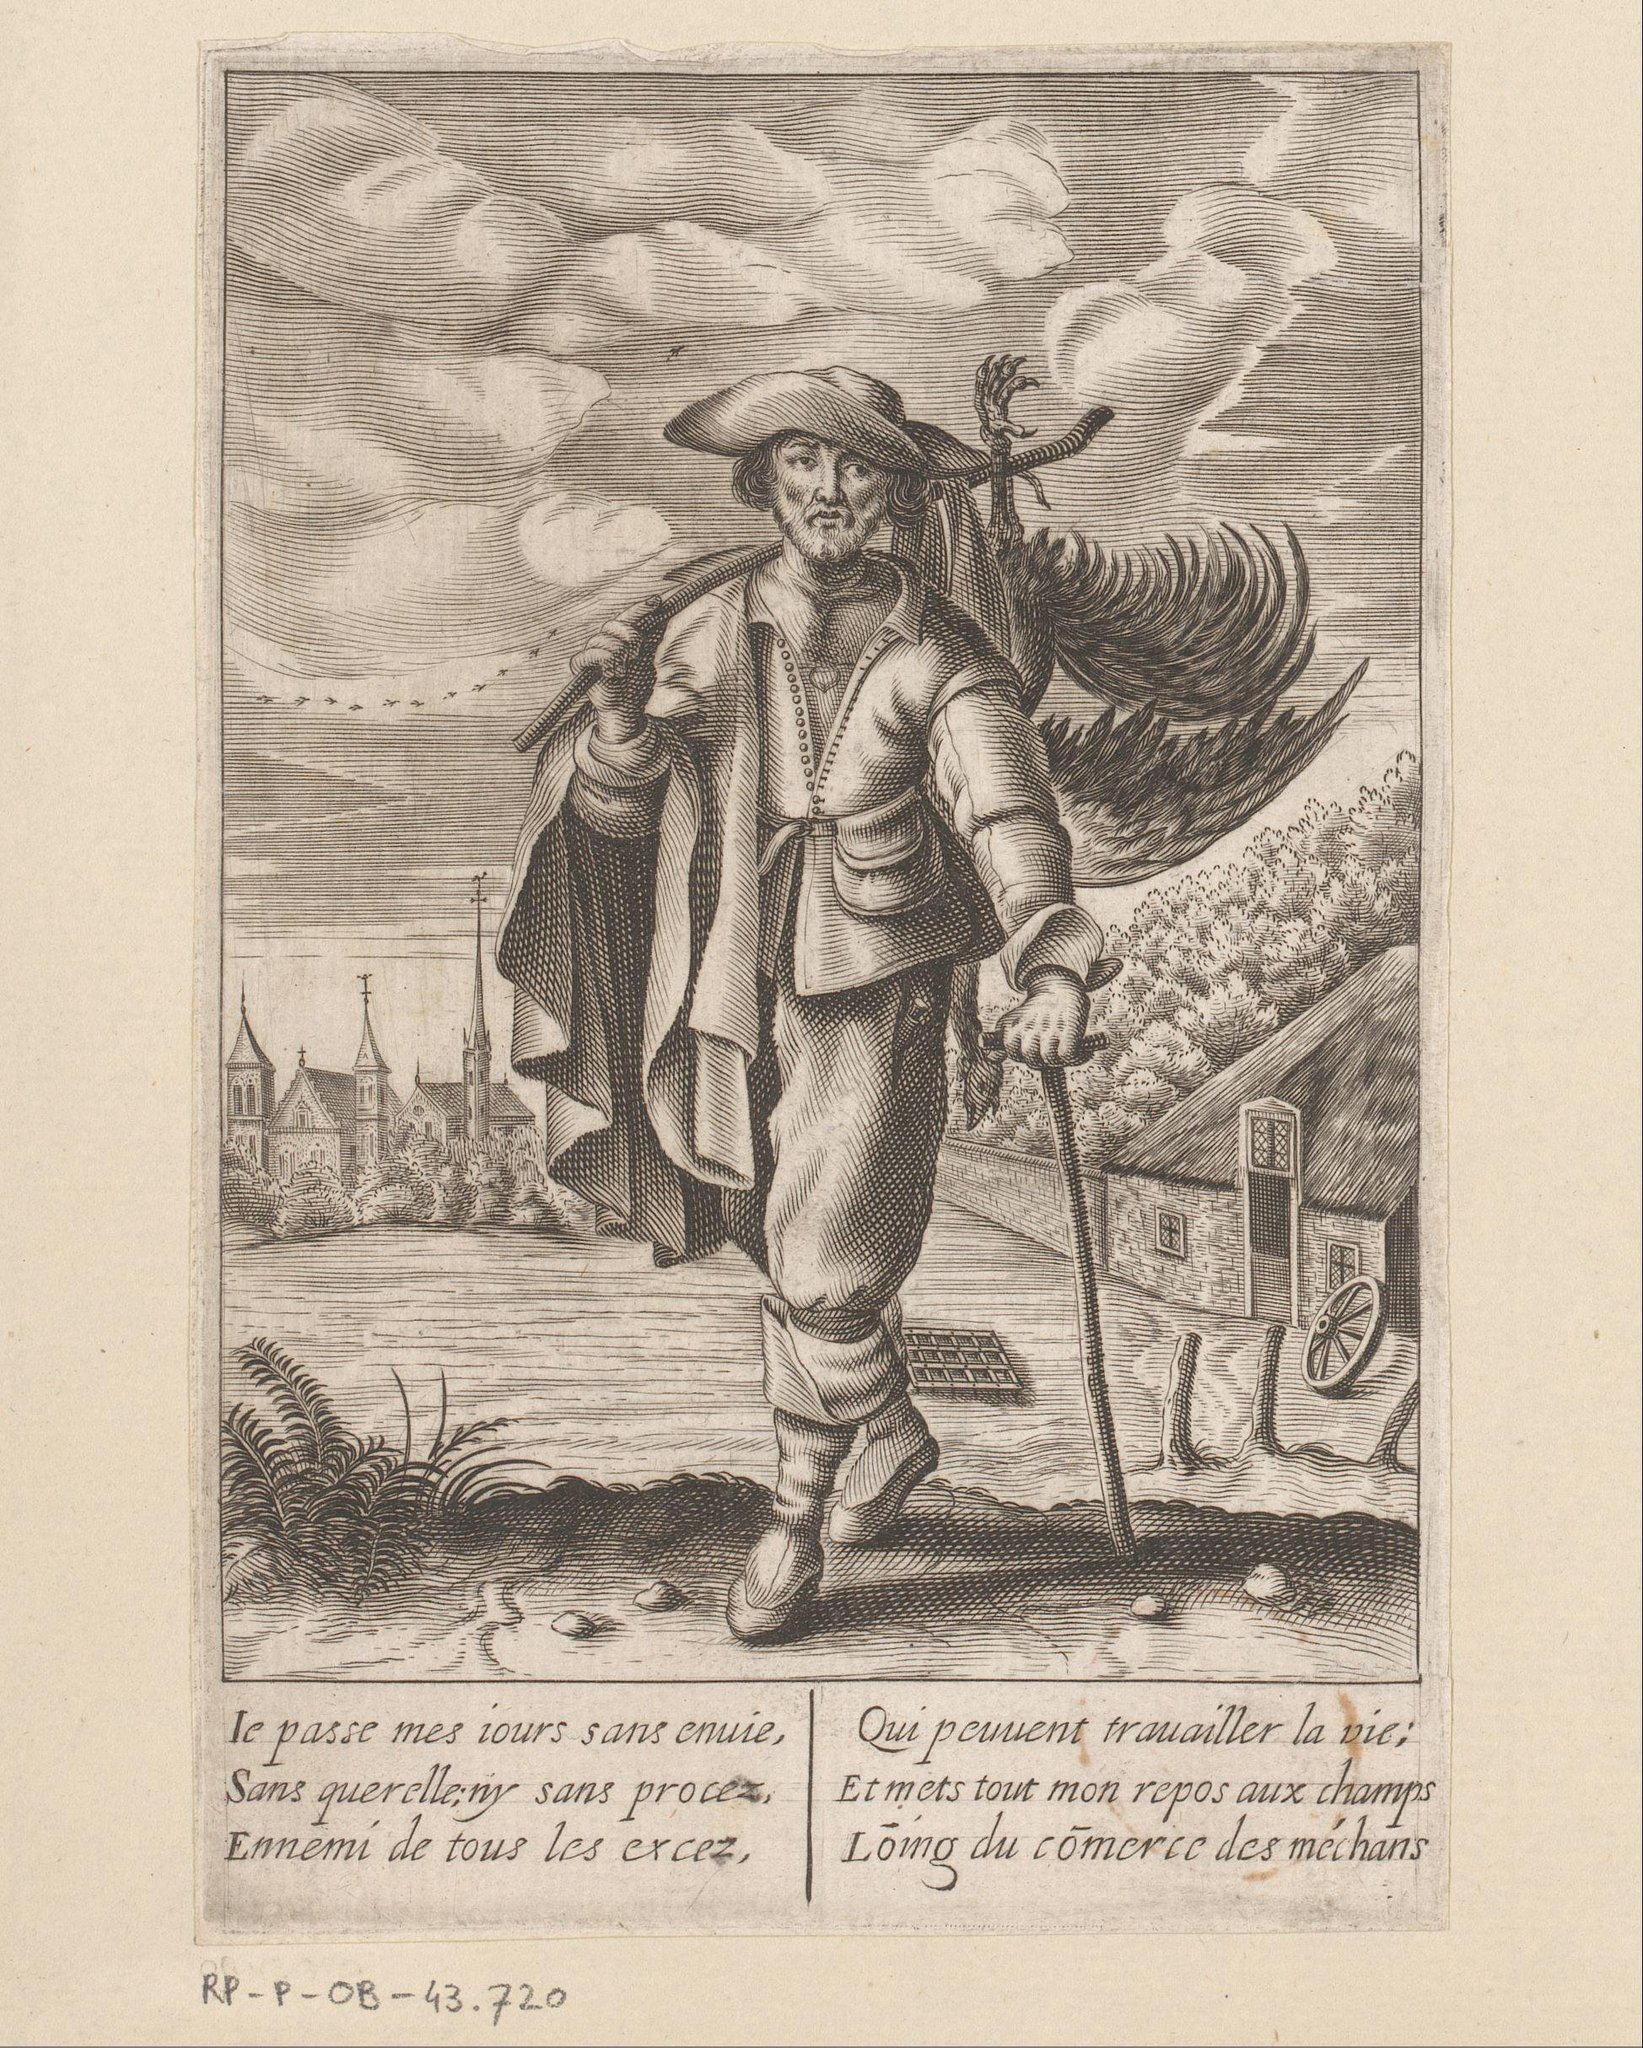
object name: print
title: Staande man met gevogelte aan een stok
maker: grégoire huret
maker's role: print maker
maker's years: 1606-1670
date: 1616-1670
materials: paper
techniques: engraving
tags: walking-stick, staff, fowl (cock, hen, chicken, etc.)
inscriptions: collector's mark: Lugt 240